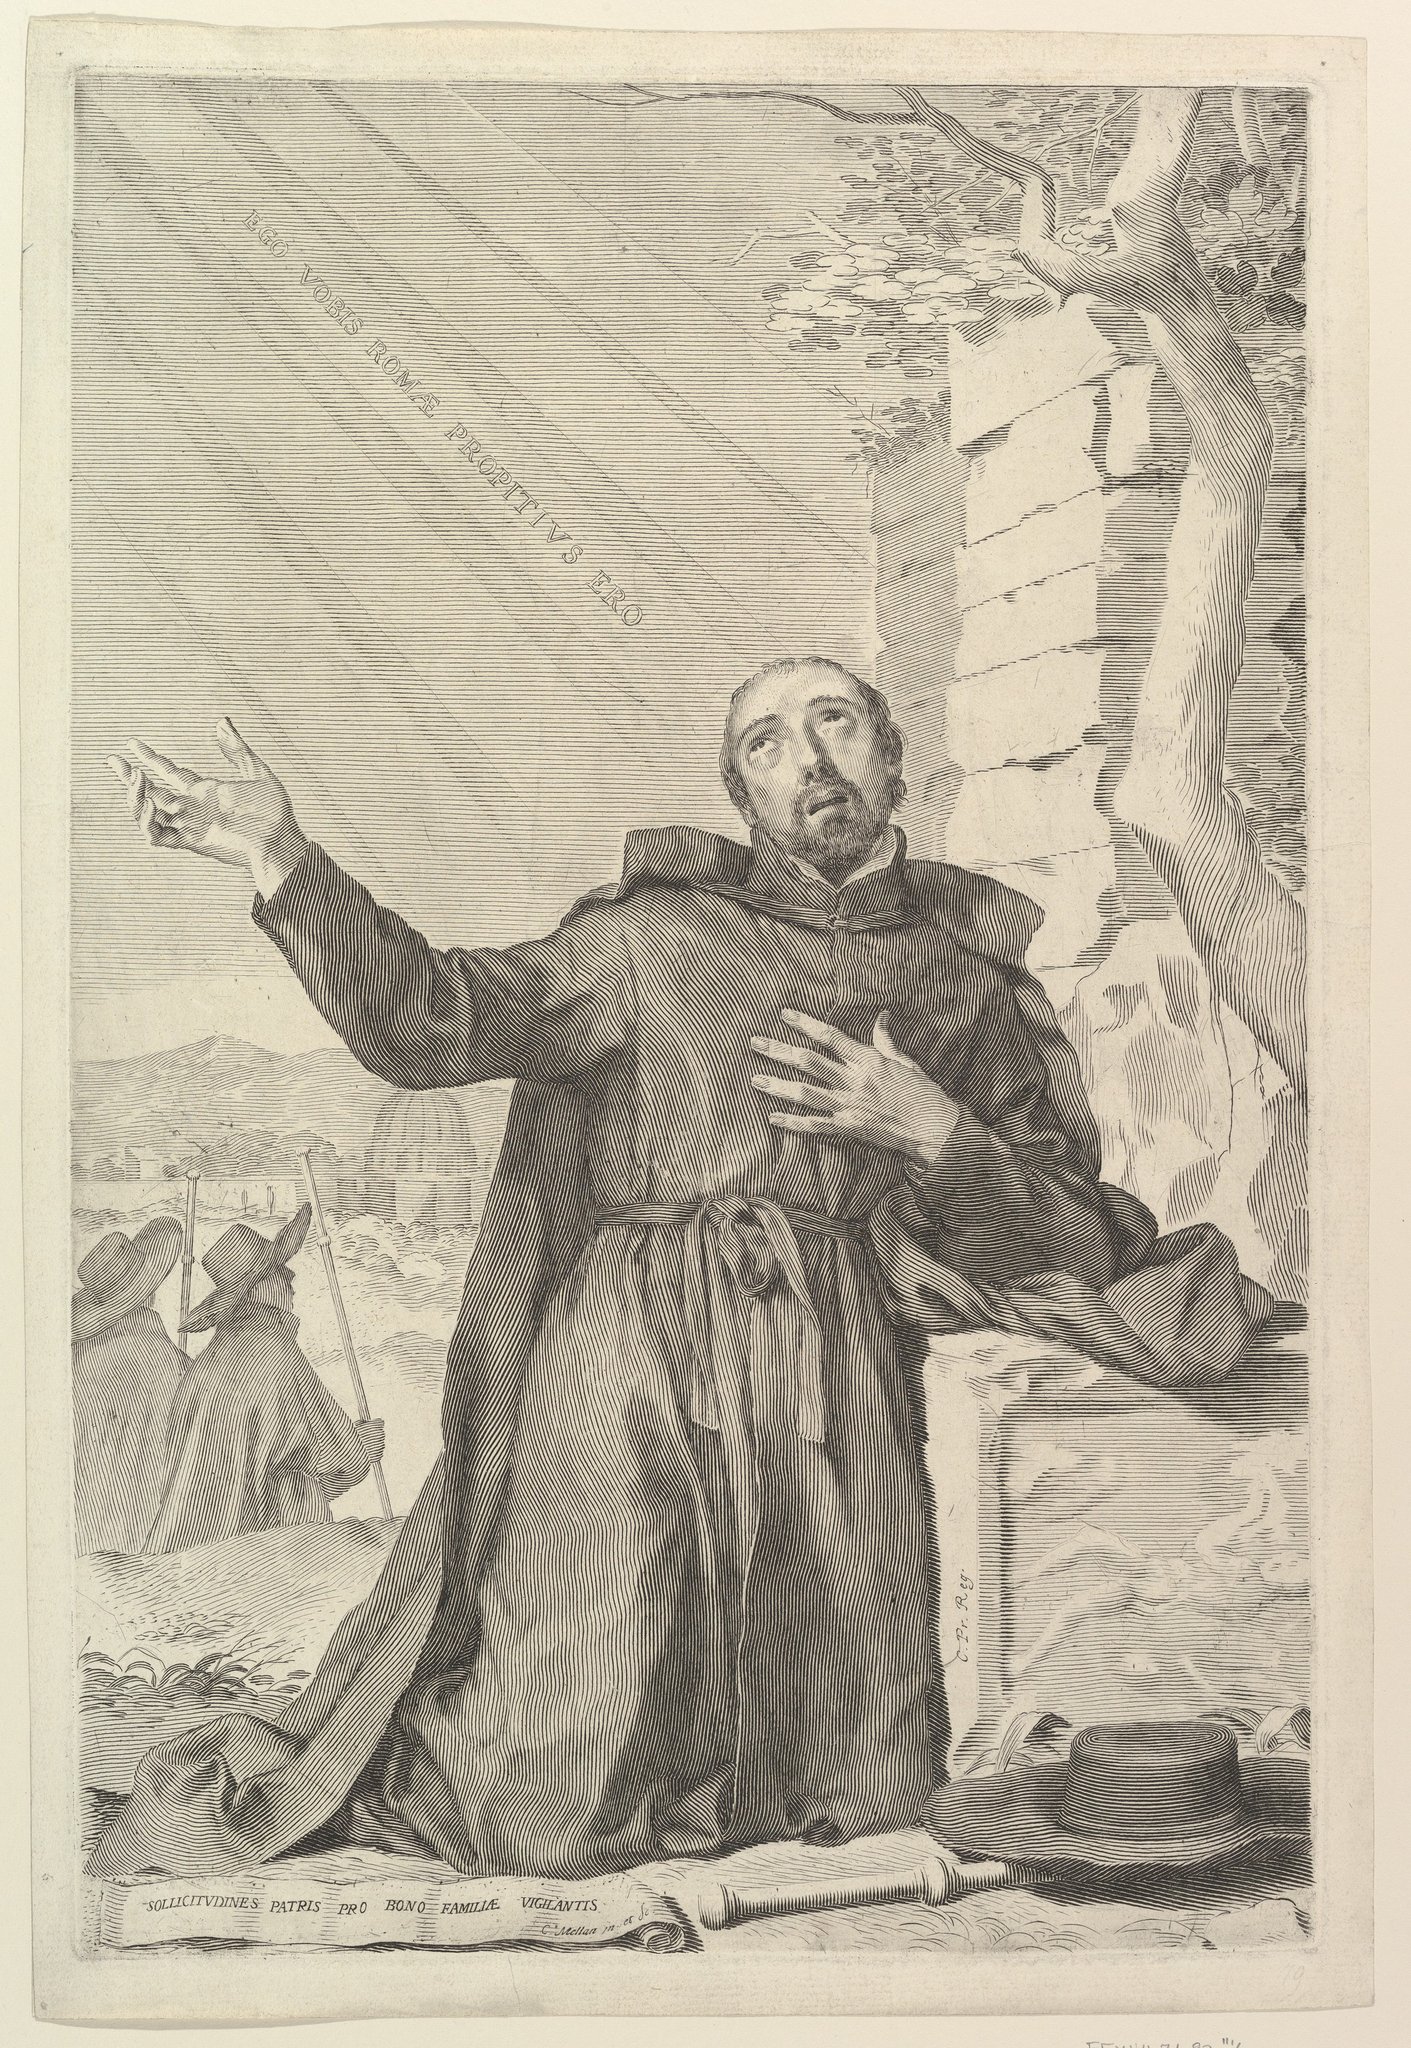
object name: print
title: St. Ignatius in Ecstasy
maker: claude mellan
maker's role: artist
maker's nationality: french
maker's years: 1598-1688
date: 1600-1688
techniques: engraving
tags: buildings,men,saints